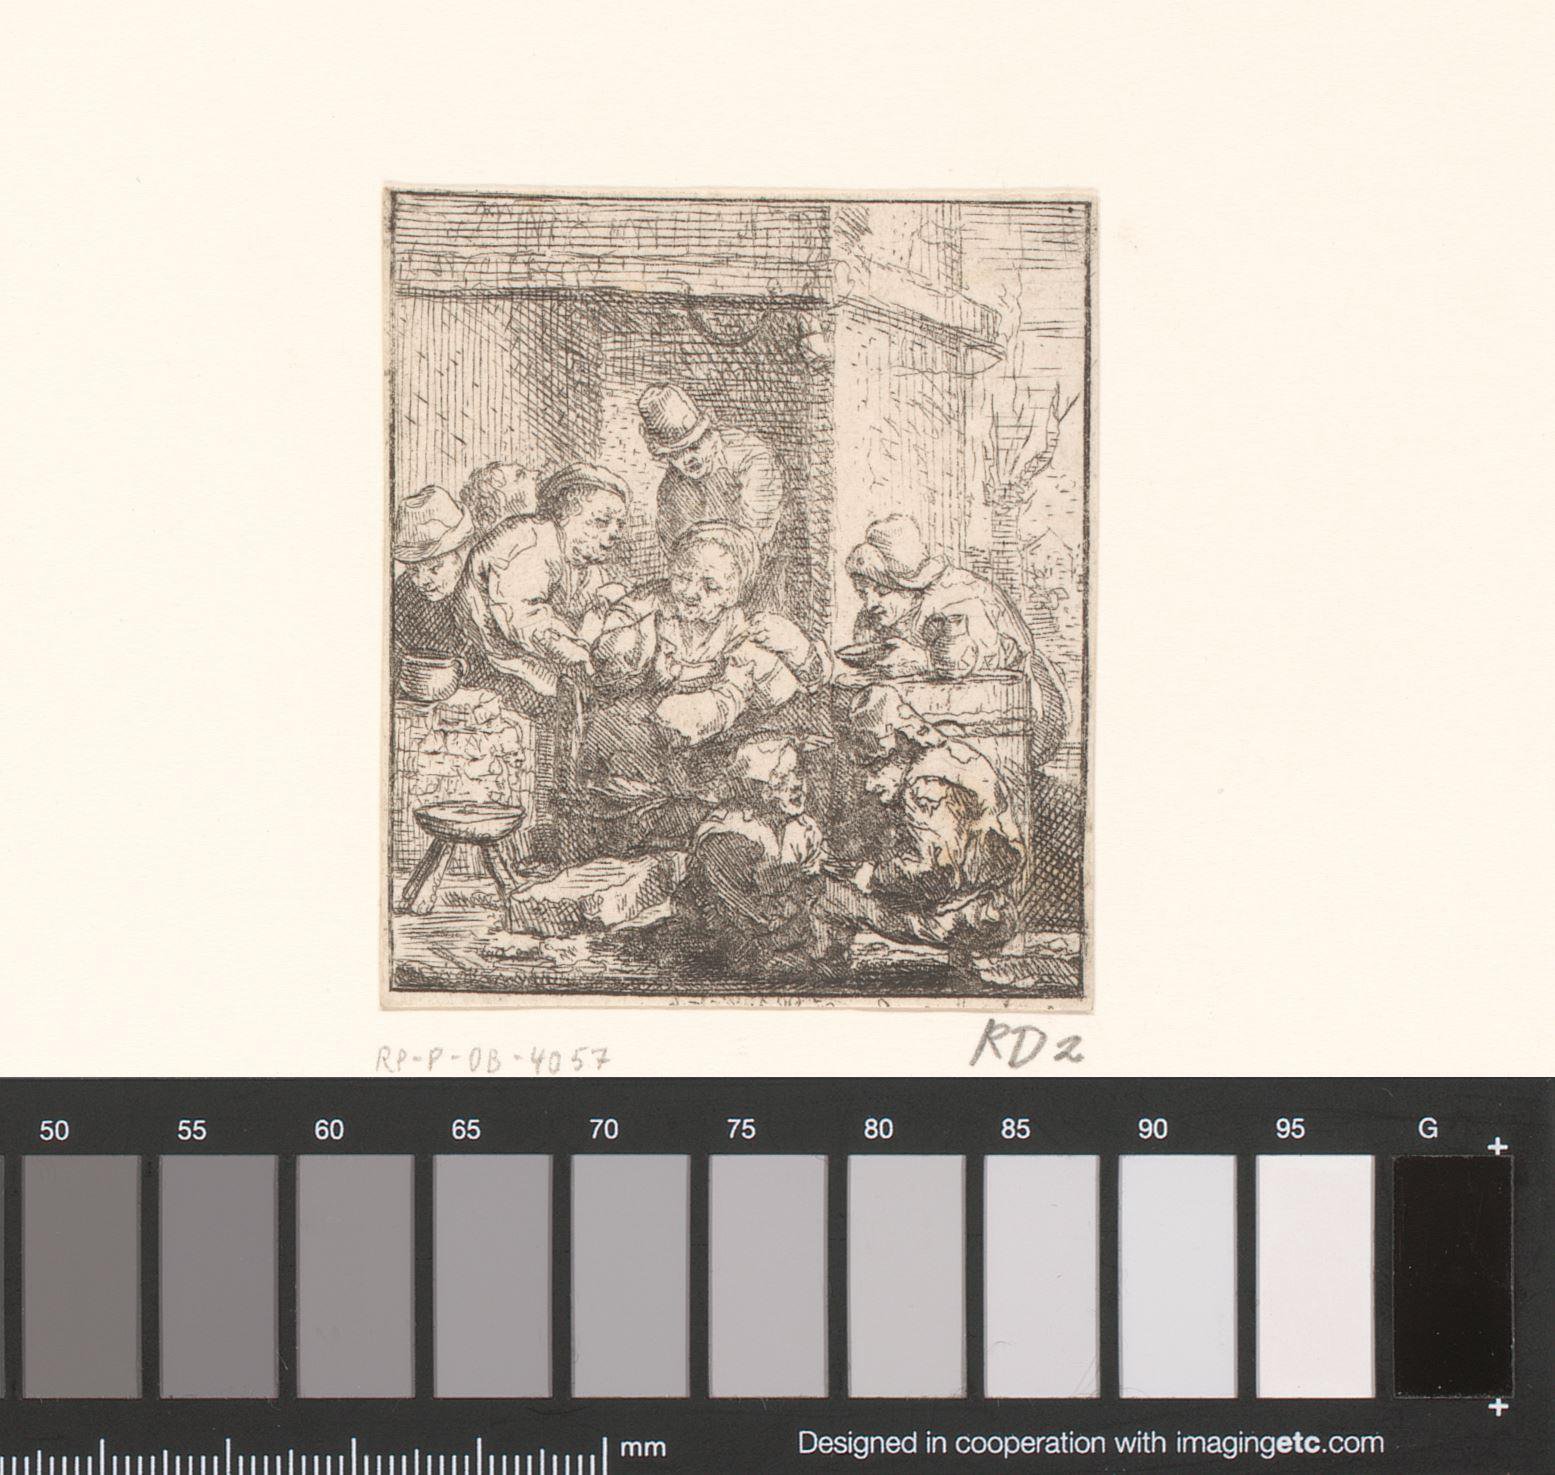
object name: print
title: Drinkend gezelschap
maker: jacques dassonville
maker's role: print maker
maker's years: 1619-1670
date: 1629-1670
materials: paper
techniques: engraving, etching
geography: france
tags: beer, ale, drinking, private festivities, merry company